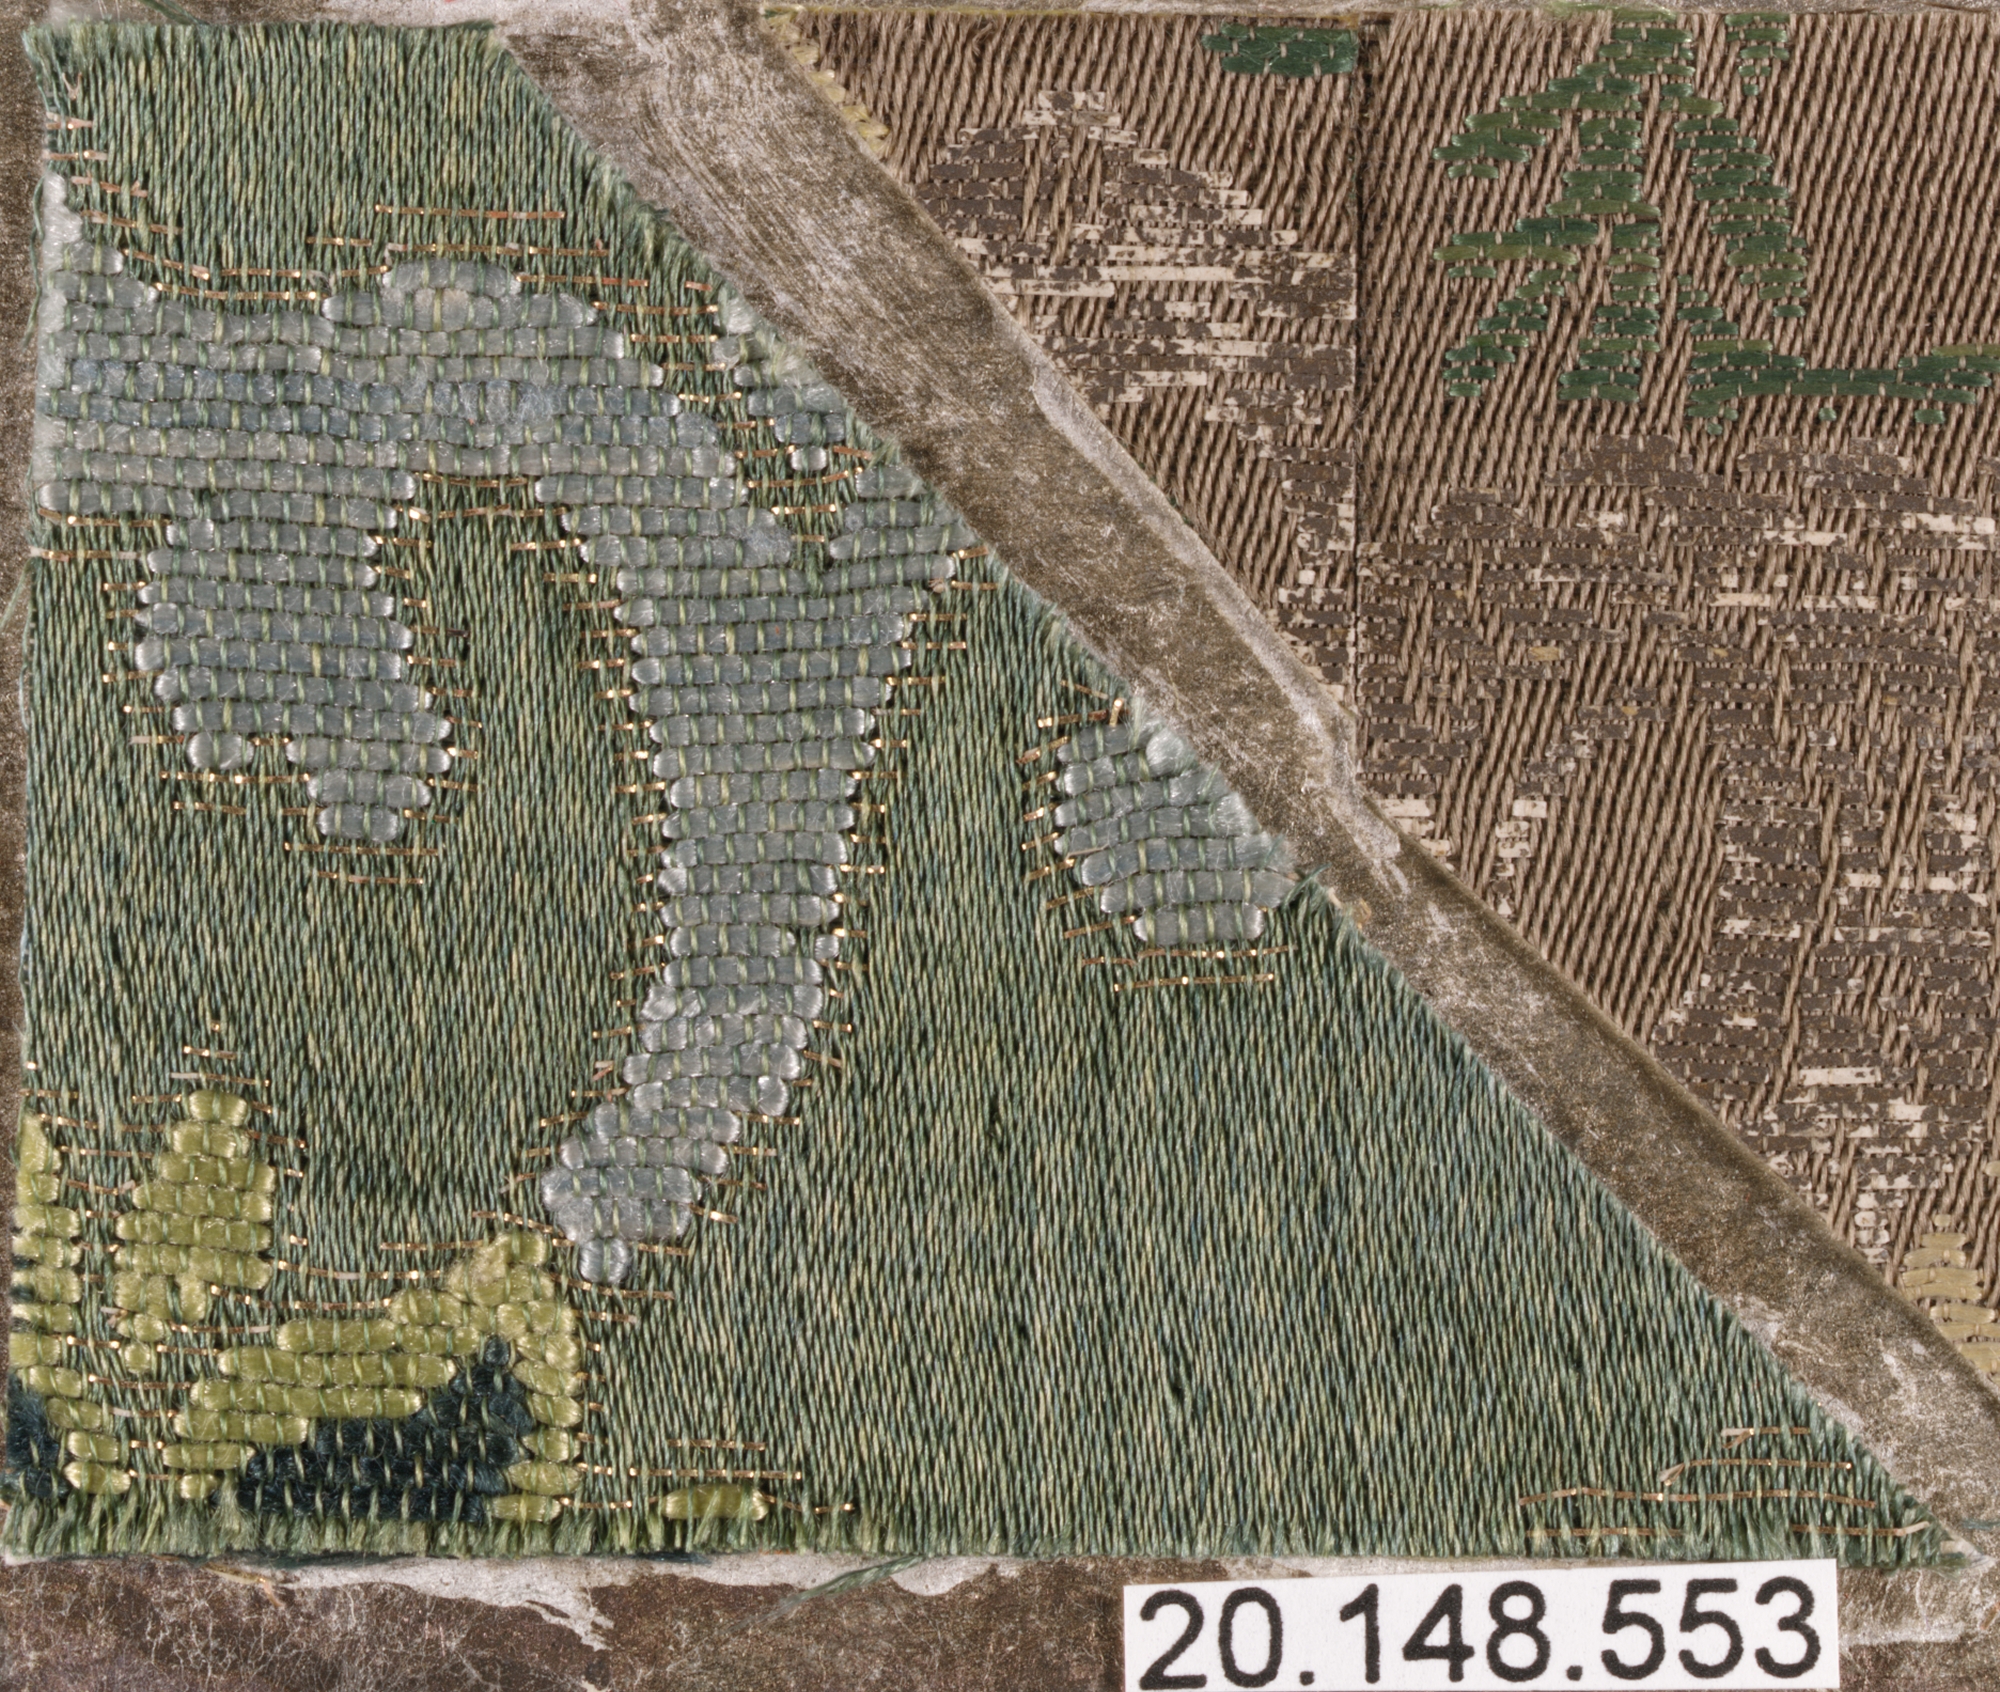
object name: piece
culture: chinese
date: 1701-1800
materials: silk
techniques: compound weave